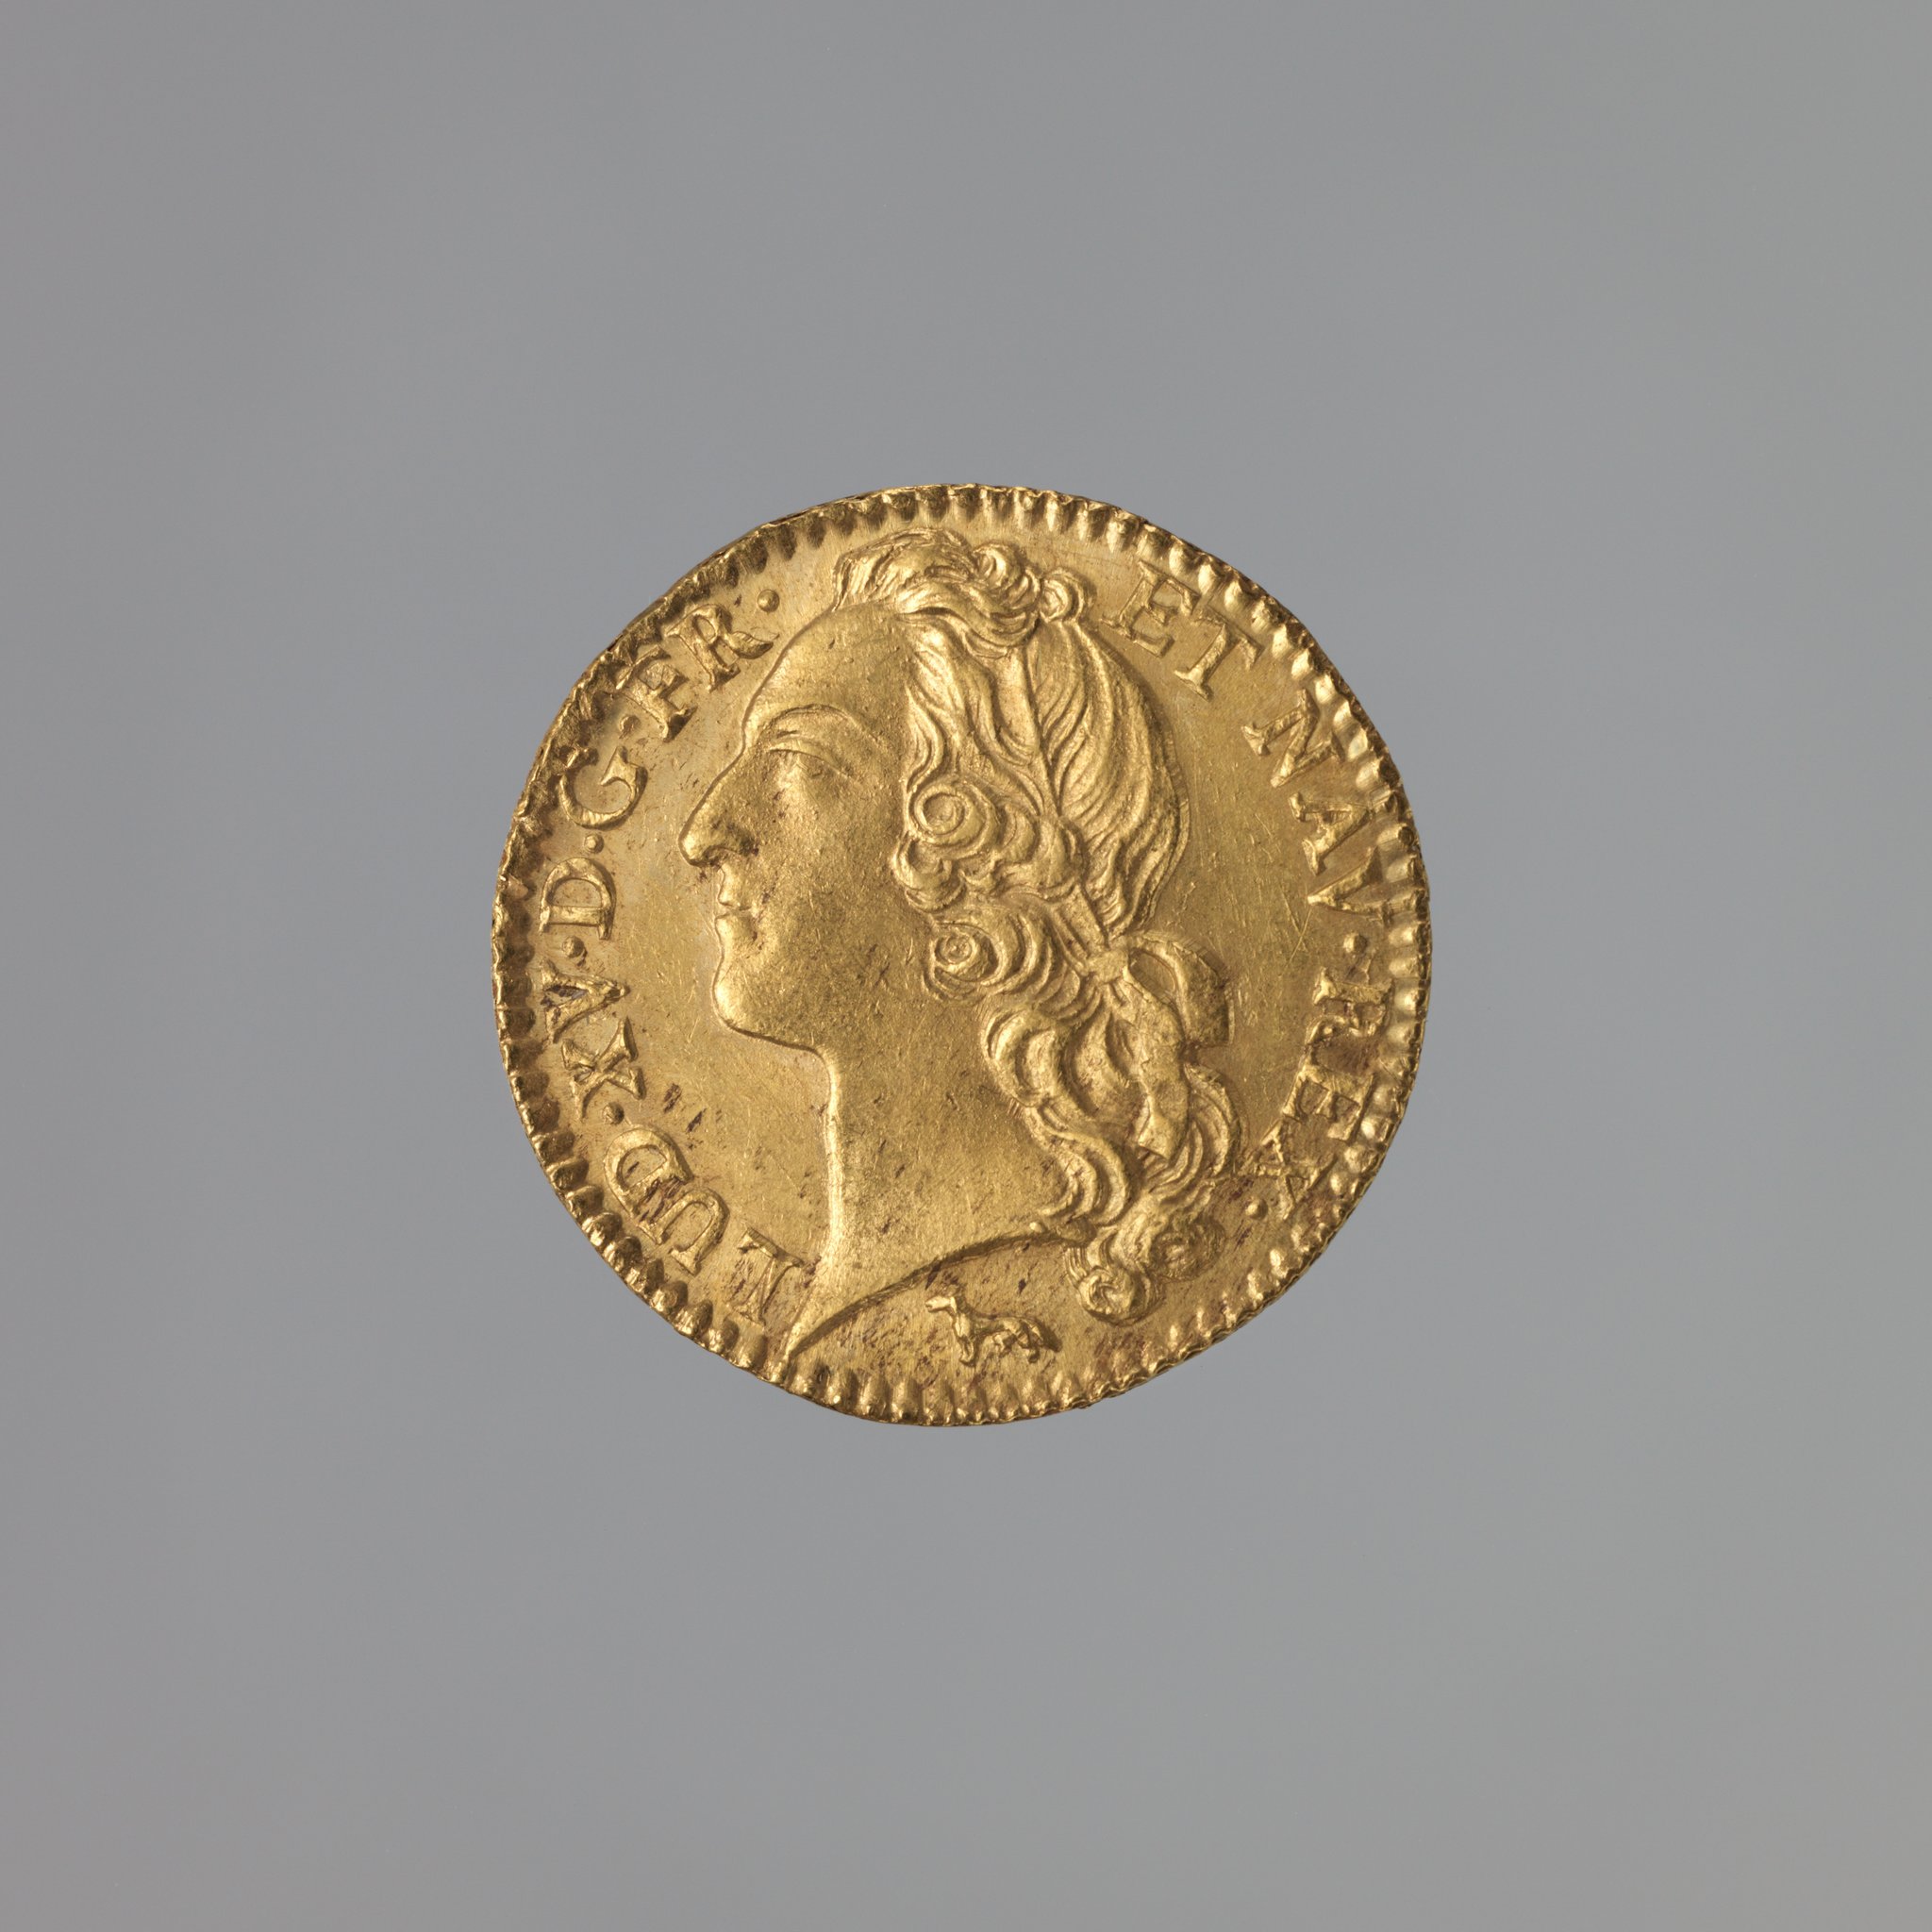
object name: coin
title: Double Louis d’or of Louis XV of France (b. 1710; r. 1715–74)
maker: joseph-charles roettiers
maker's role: maker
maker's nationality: french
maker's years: 1691-1779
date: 1755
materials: gold